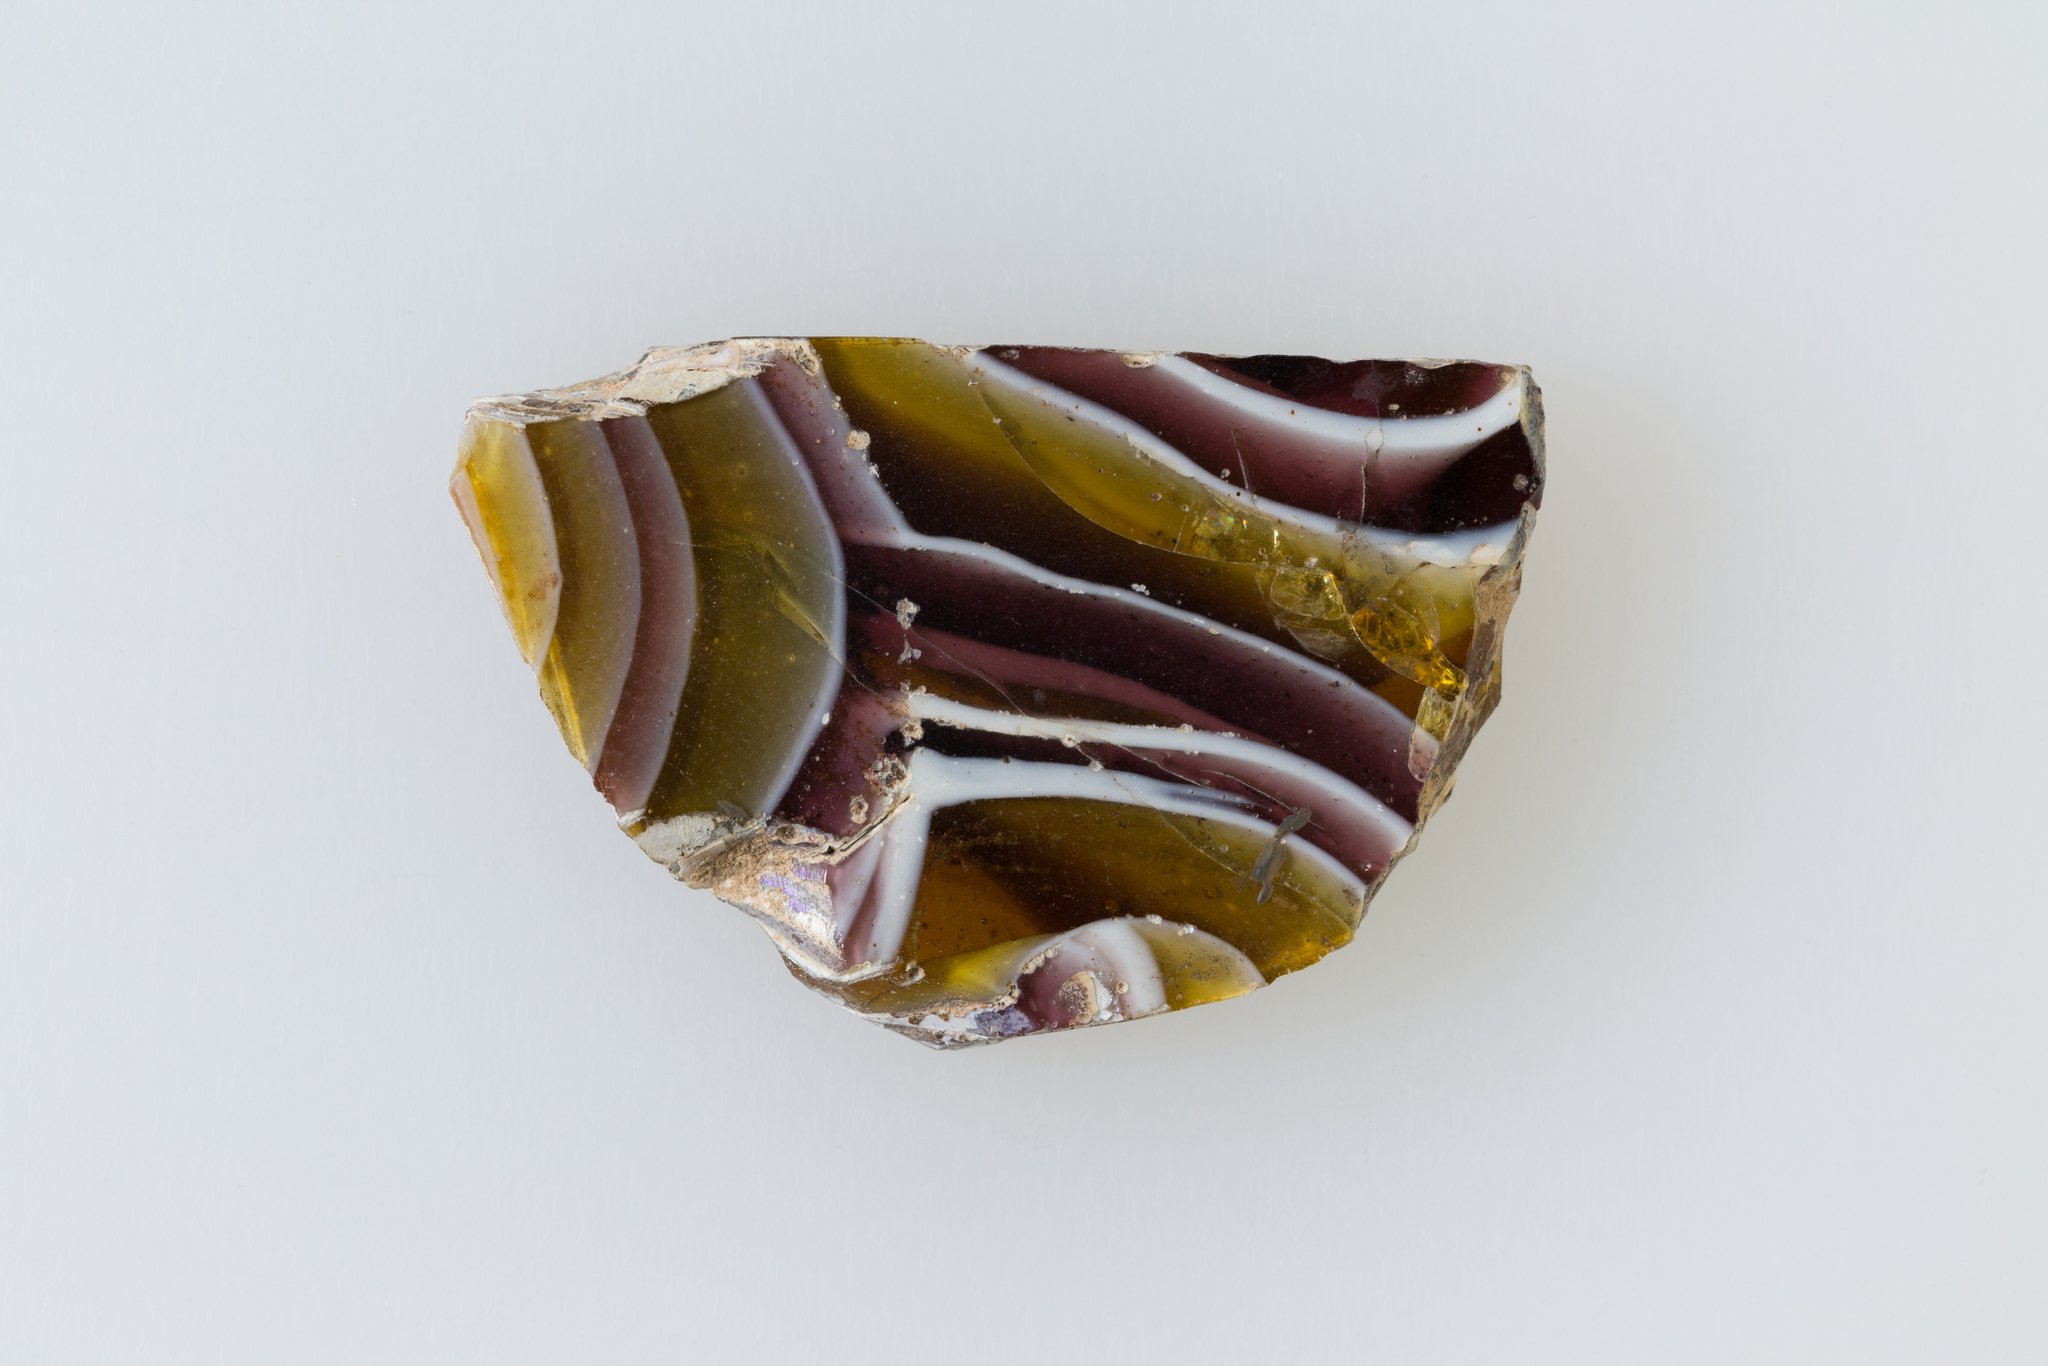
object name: wall revetment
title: Wall revetment, agate pattern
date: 200 BCE-100 CE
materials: glass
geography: egypt